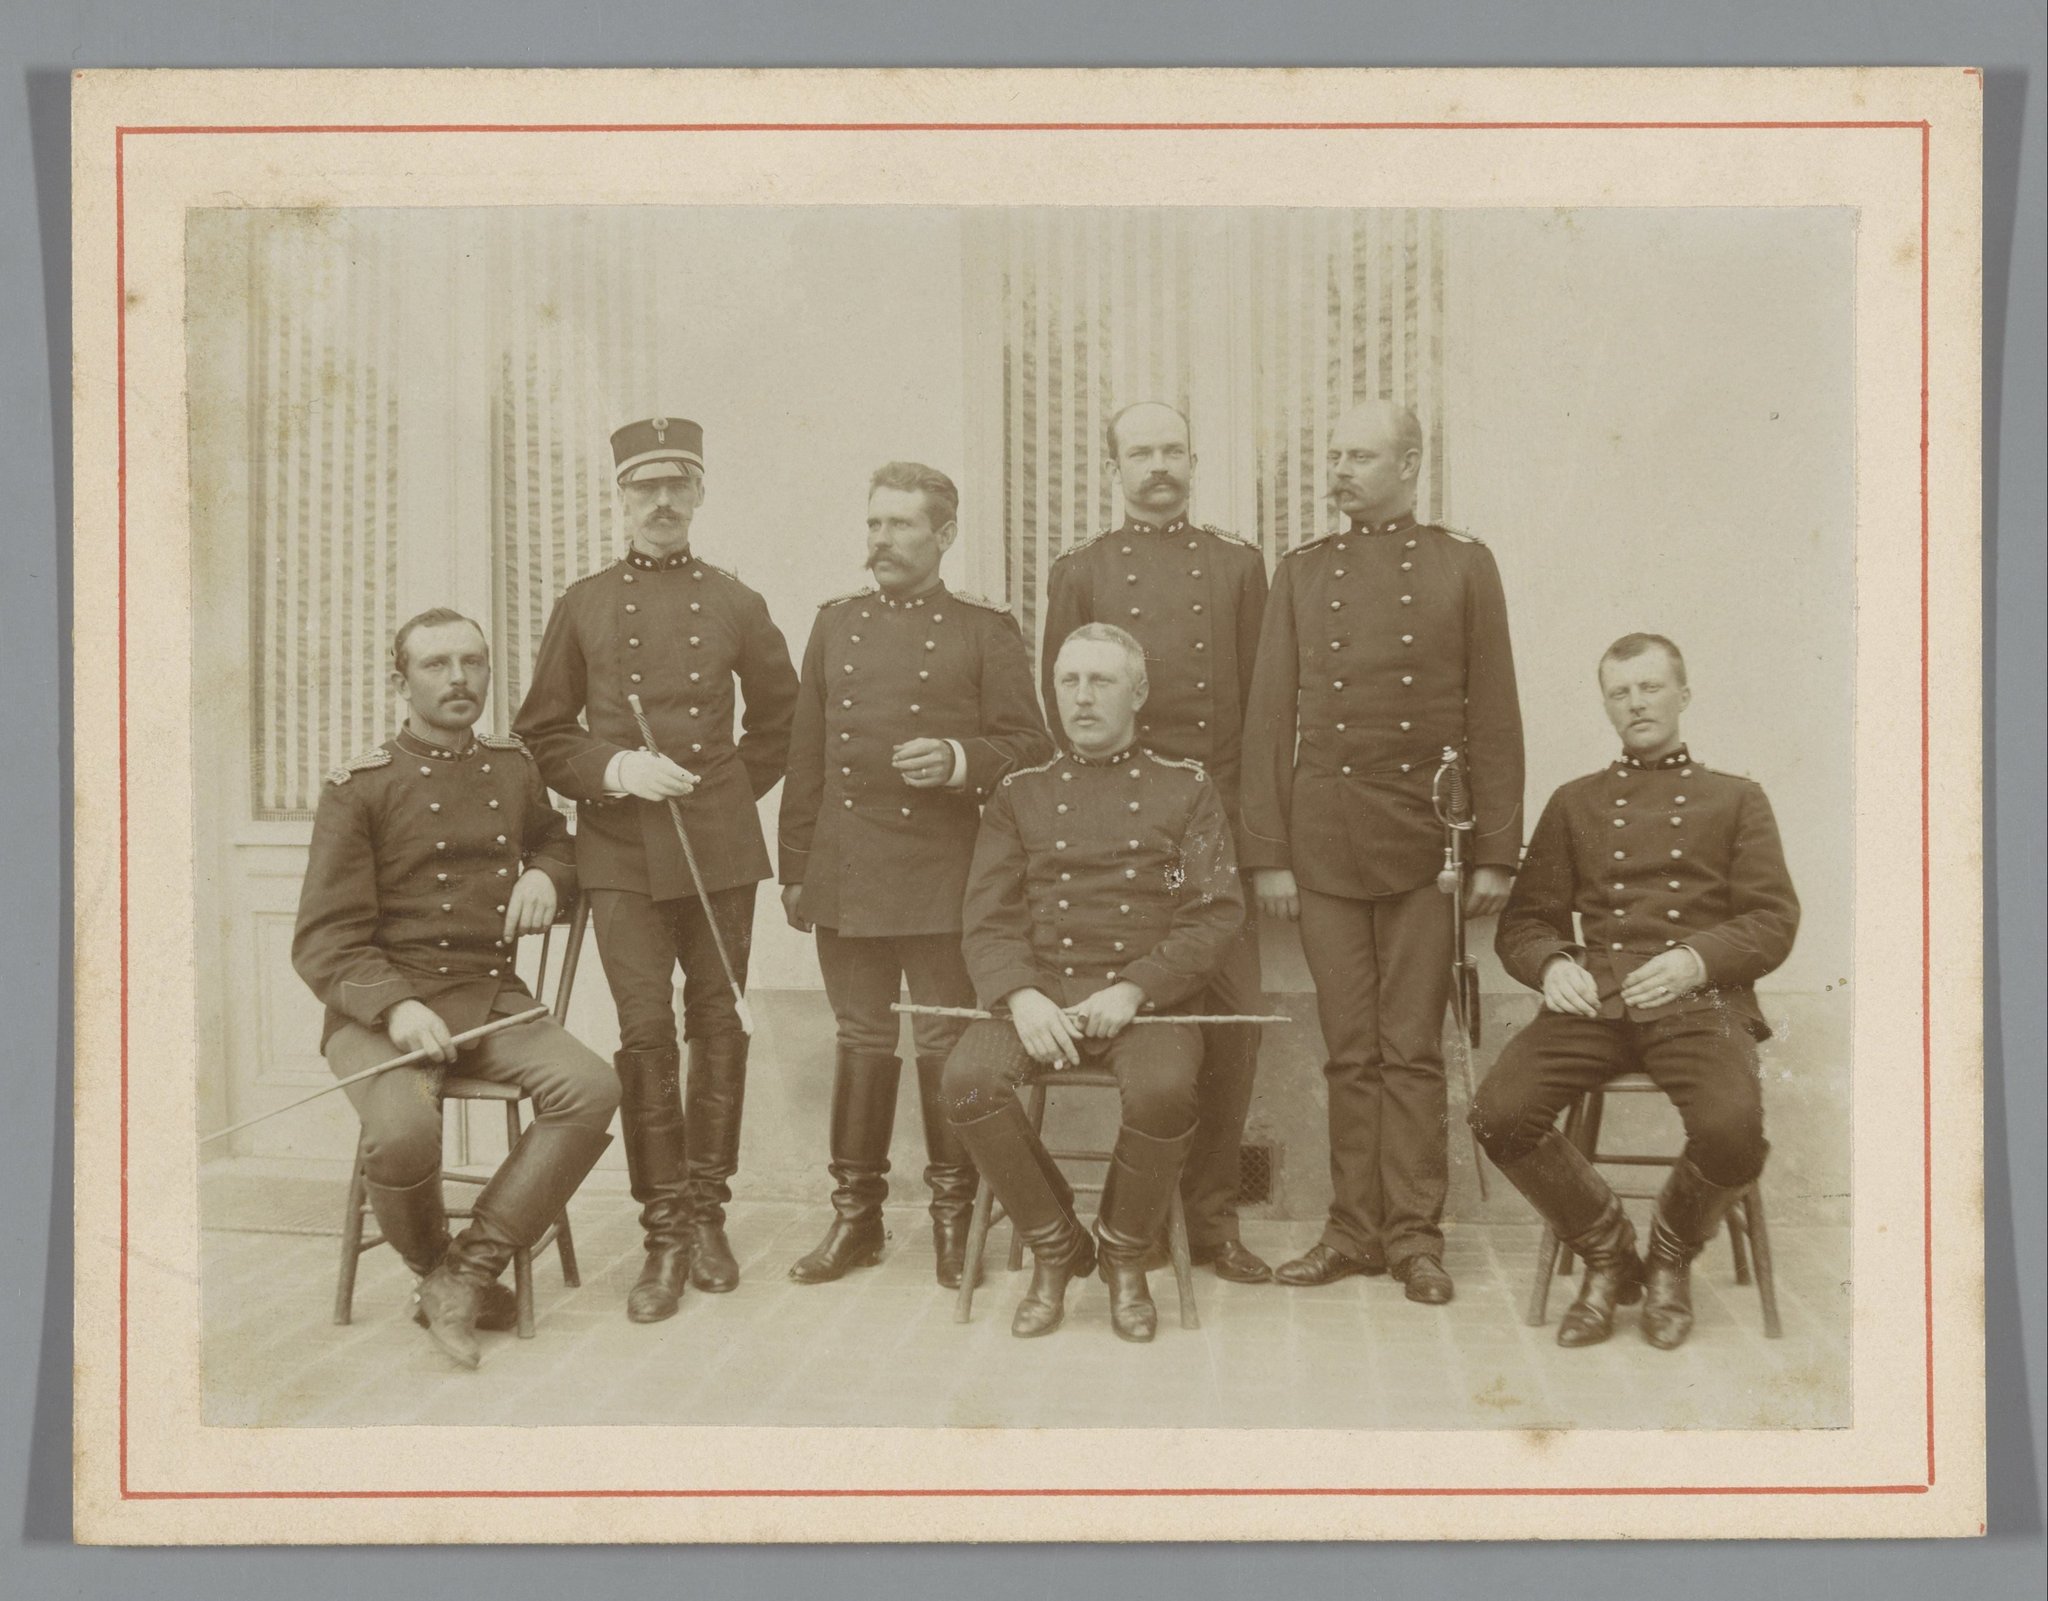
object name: photograph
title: Tafel te Bergen op Zoom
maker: karel alexander enklaar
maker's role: fotograaf, luitenant, militair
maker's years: 1858-1943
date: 1808-1892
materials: paper, cardboard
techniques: collodion silver print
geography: bergen op zoom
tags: land forces, (military) uniforms, anonymous historical persons portrayed in a group, in a group-portrait, bergen op zoom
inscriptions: collector's mark: ‘Vosmaer’, inscription: ‘gef. door Enklaar Aug. 92’